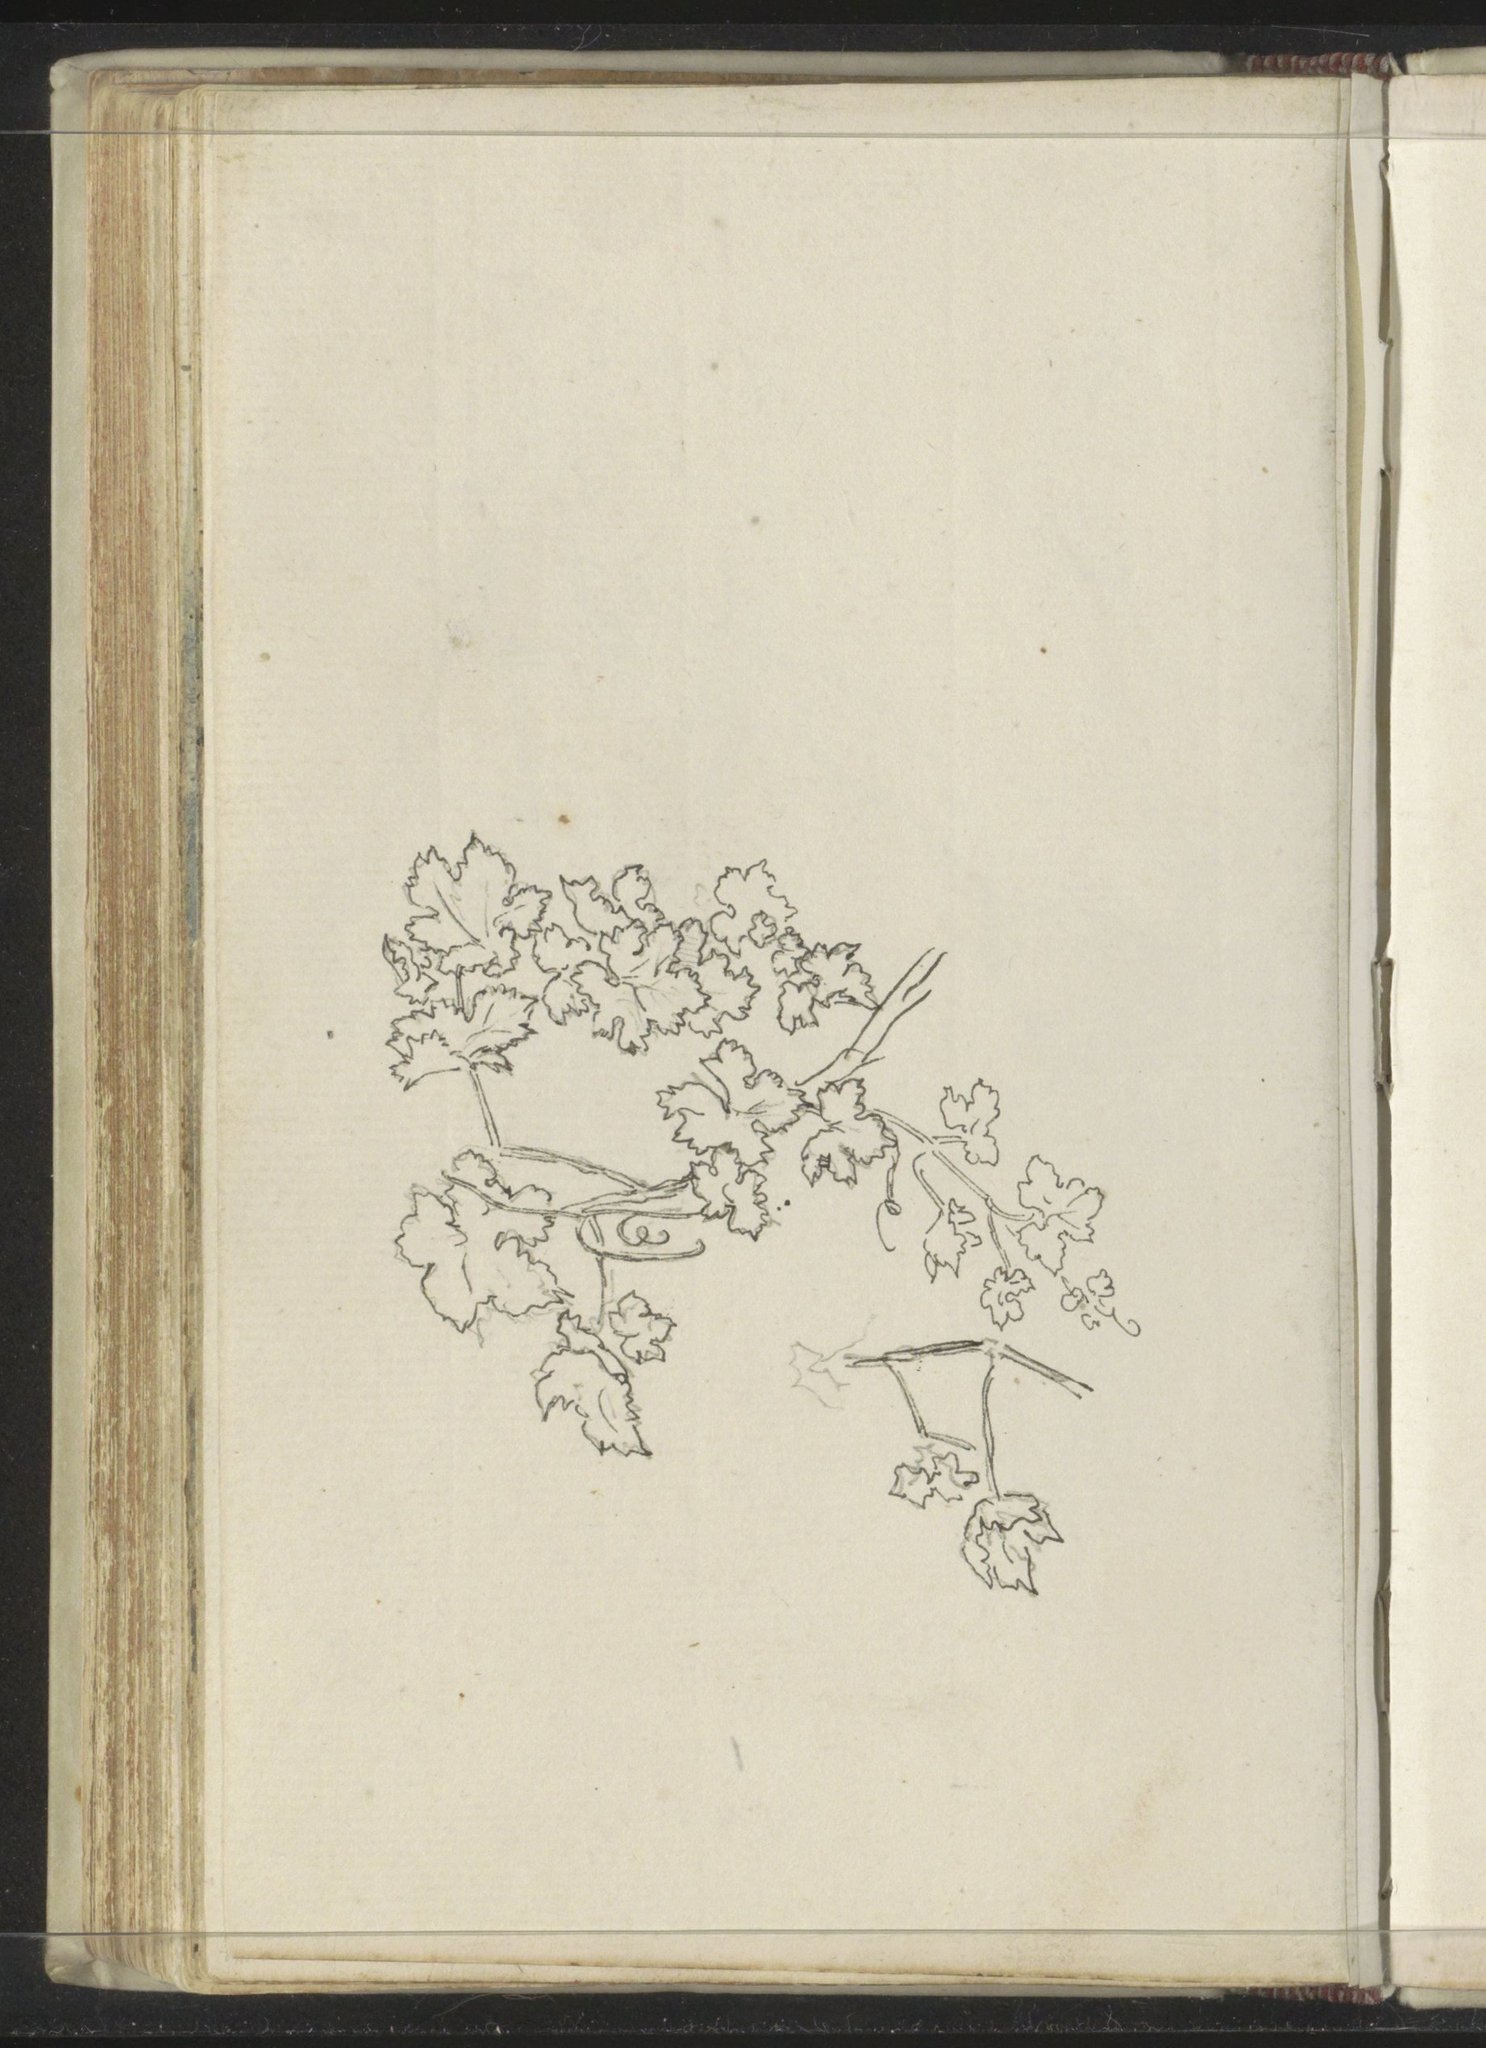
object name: sketchbook leaf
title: Takken met bladeren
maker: johannes huibert prins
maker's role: draughtsman, painter, print maker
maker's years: 1757-1806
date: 1783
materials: ink, paper, pencil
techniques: pen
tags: trees (+ leaf), trees (+ branch, stick)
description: Pagina 175 uit een schetsboek met 175 pagina's.